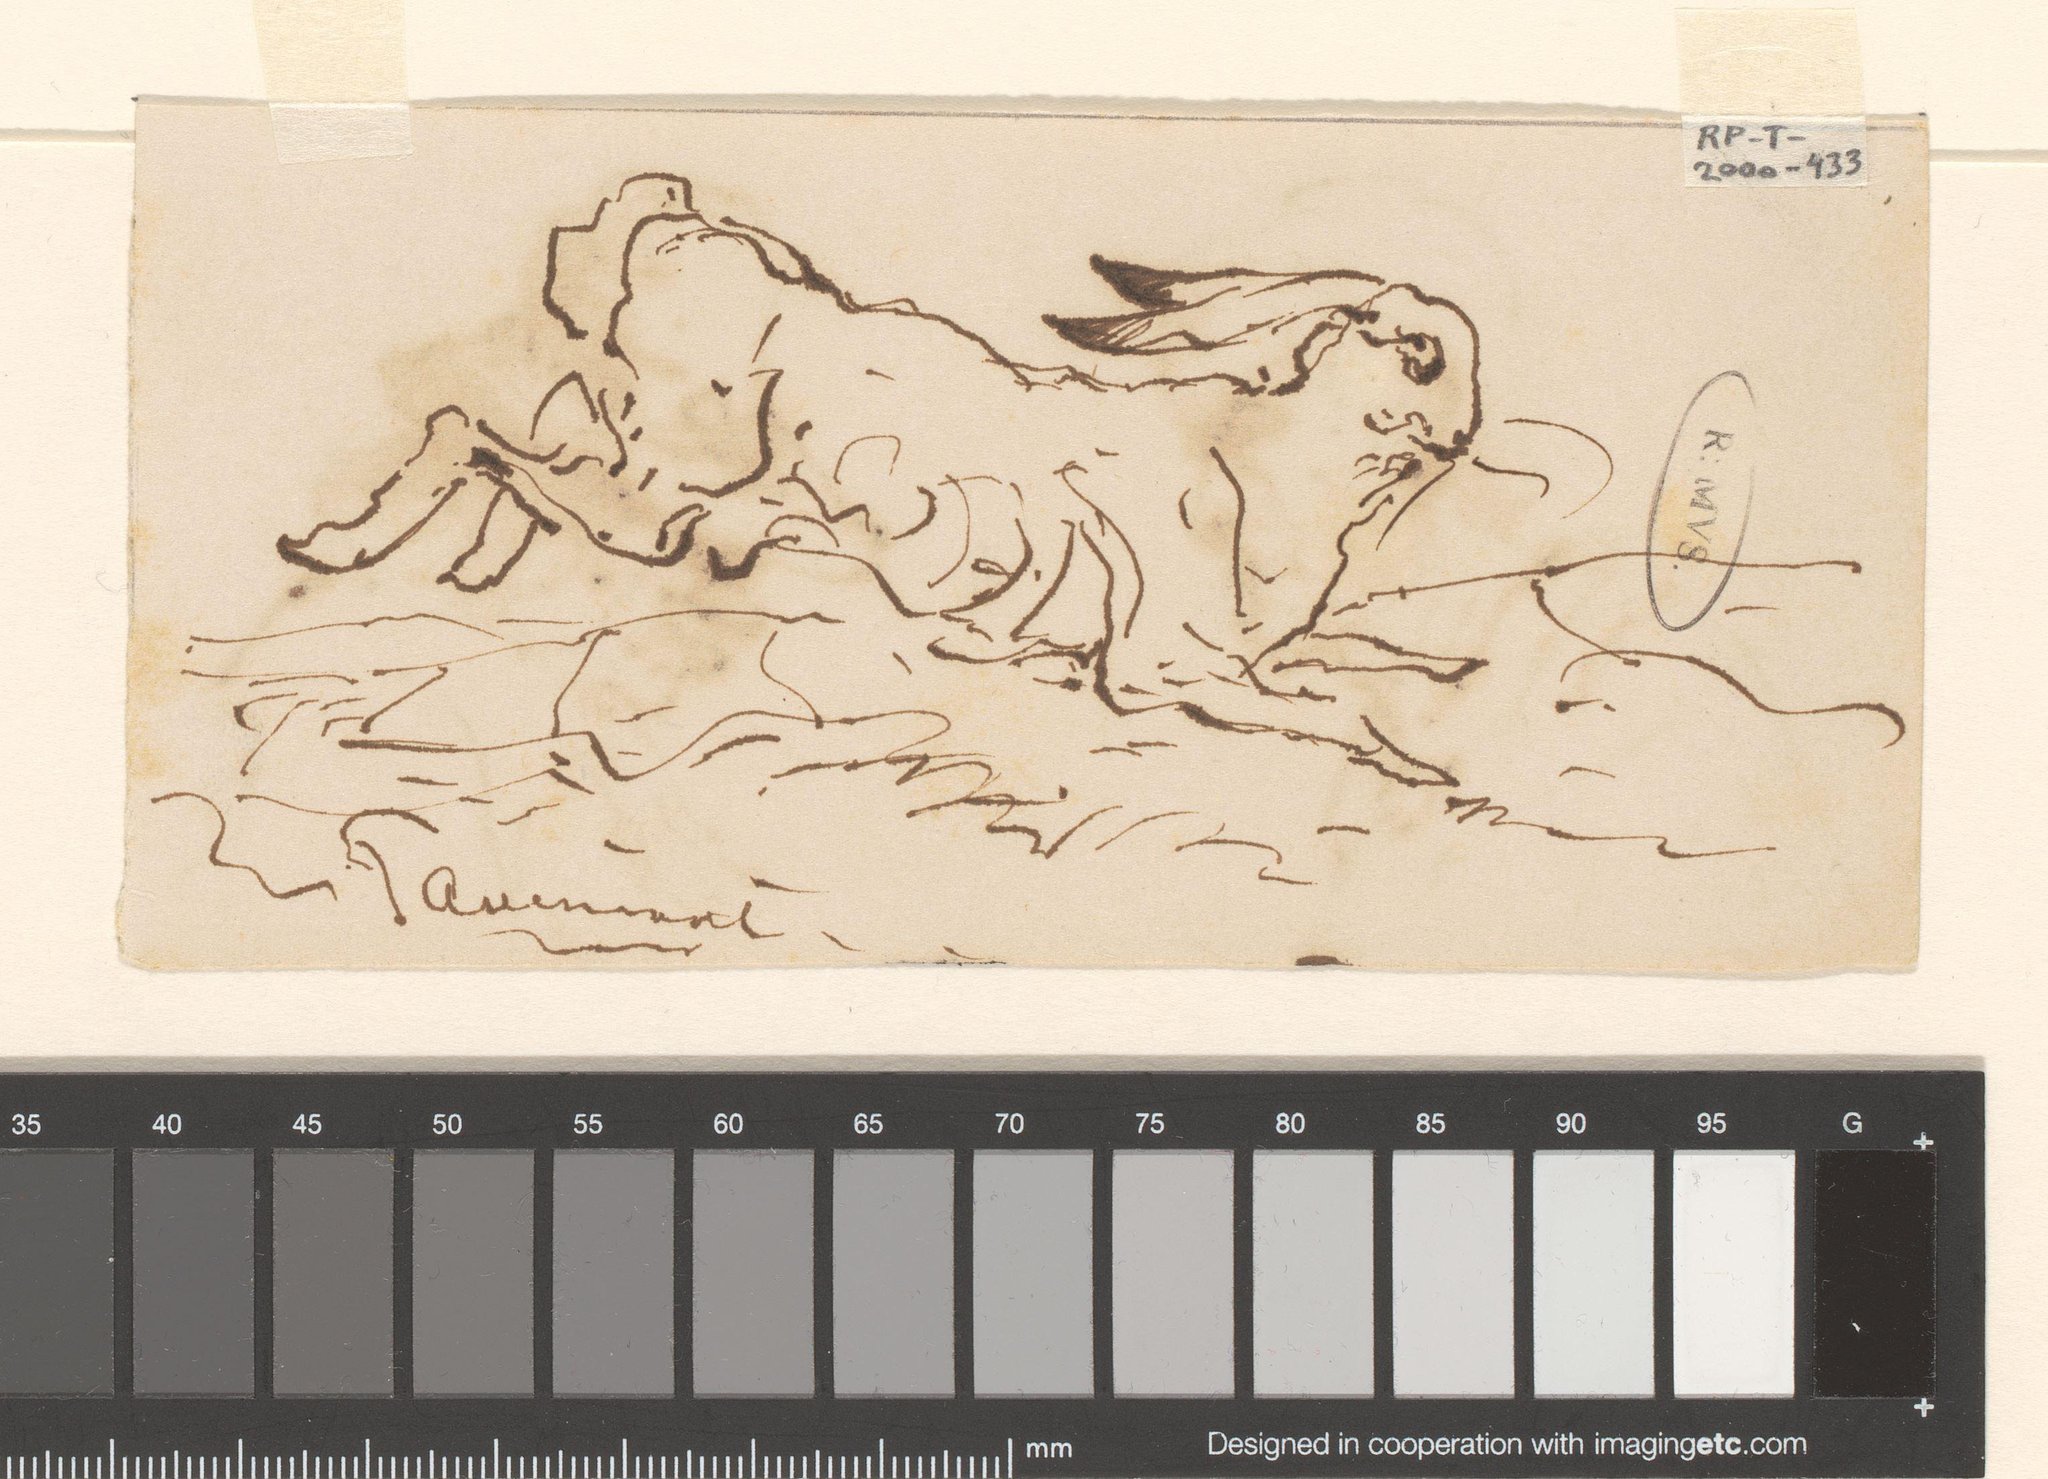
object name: drawing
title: Haas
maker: johannes tavenraat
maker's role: draughtsman, painter, print maker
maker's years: 1809-1881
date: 1840-1880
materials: ink, paper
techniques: pen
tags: rodents: hare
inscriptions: signature: ‘Tavenraat’, collector's mark: Lugt 2228